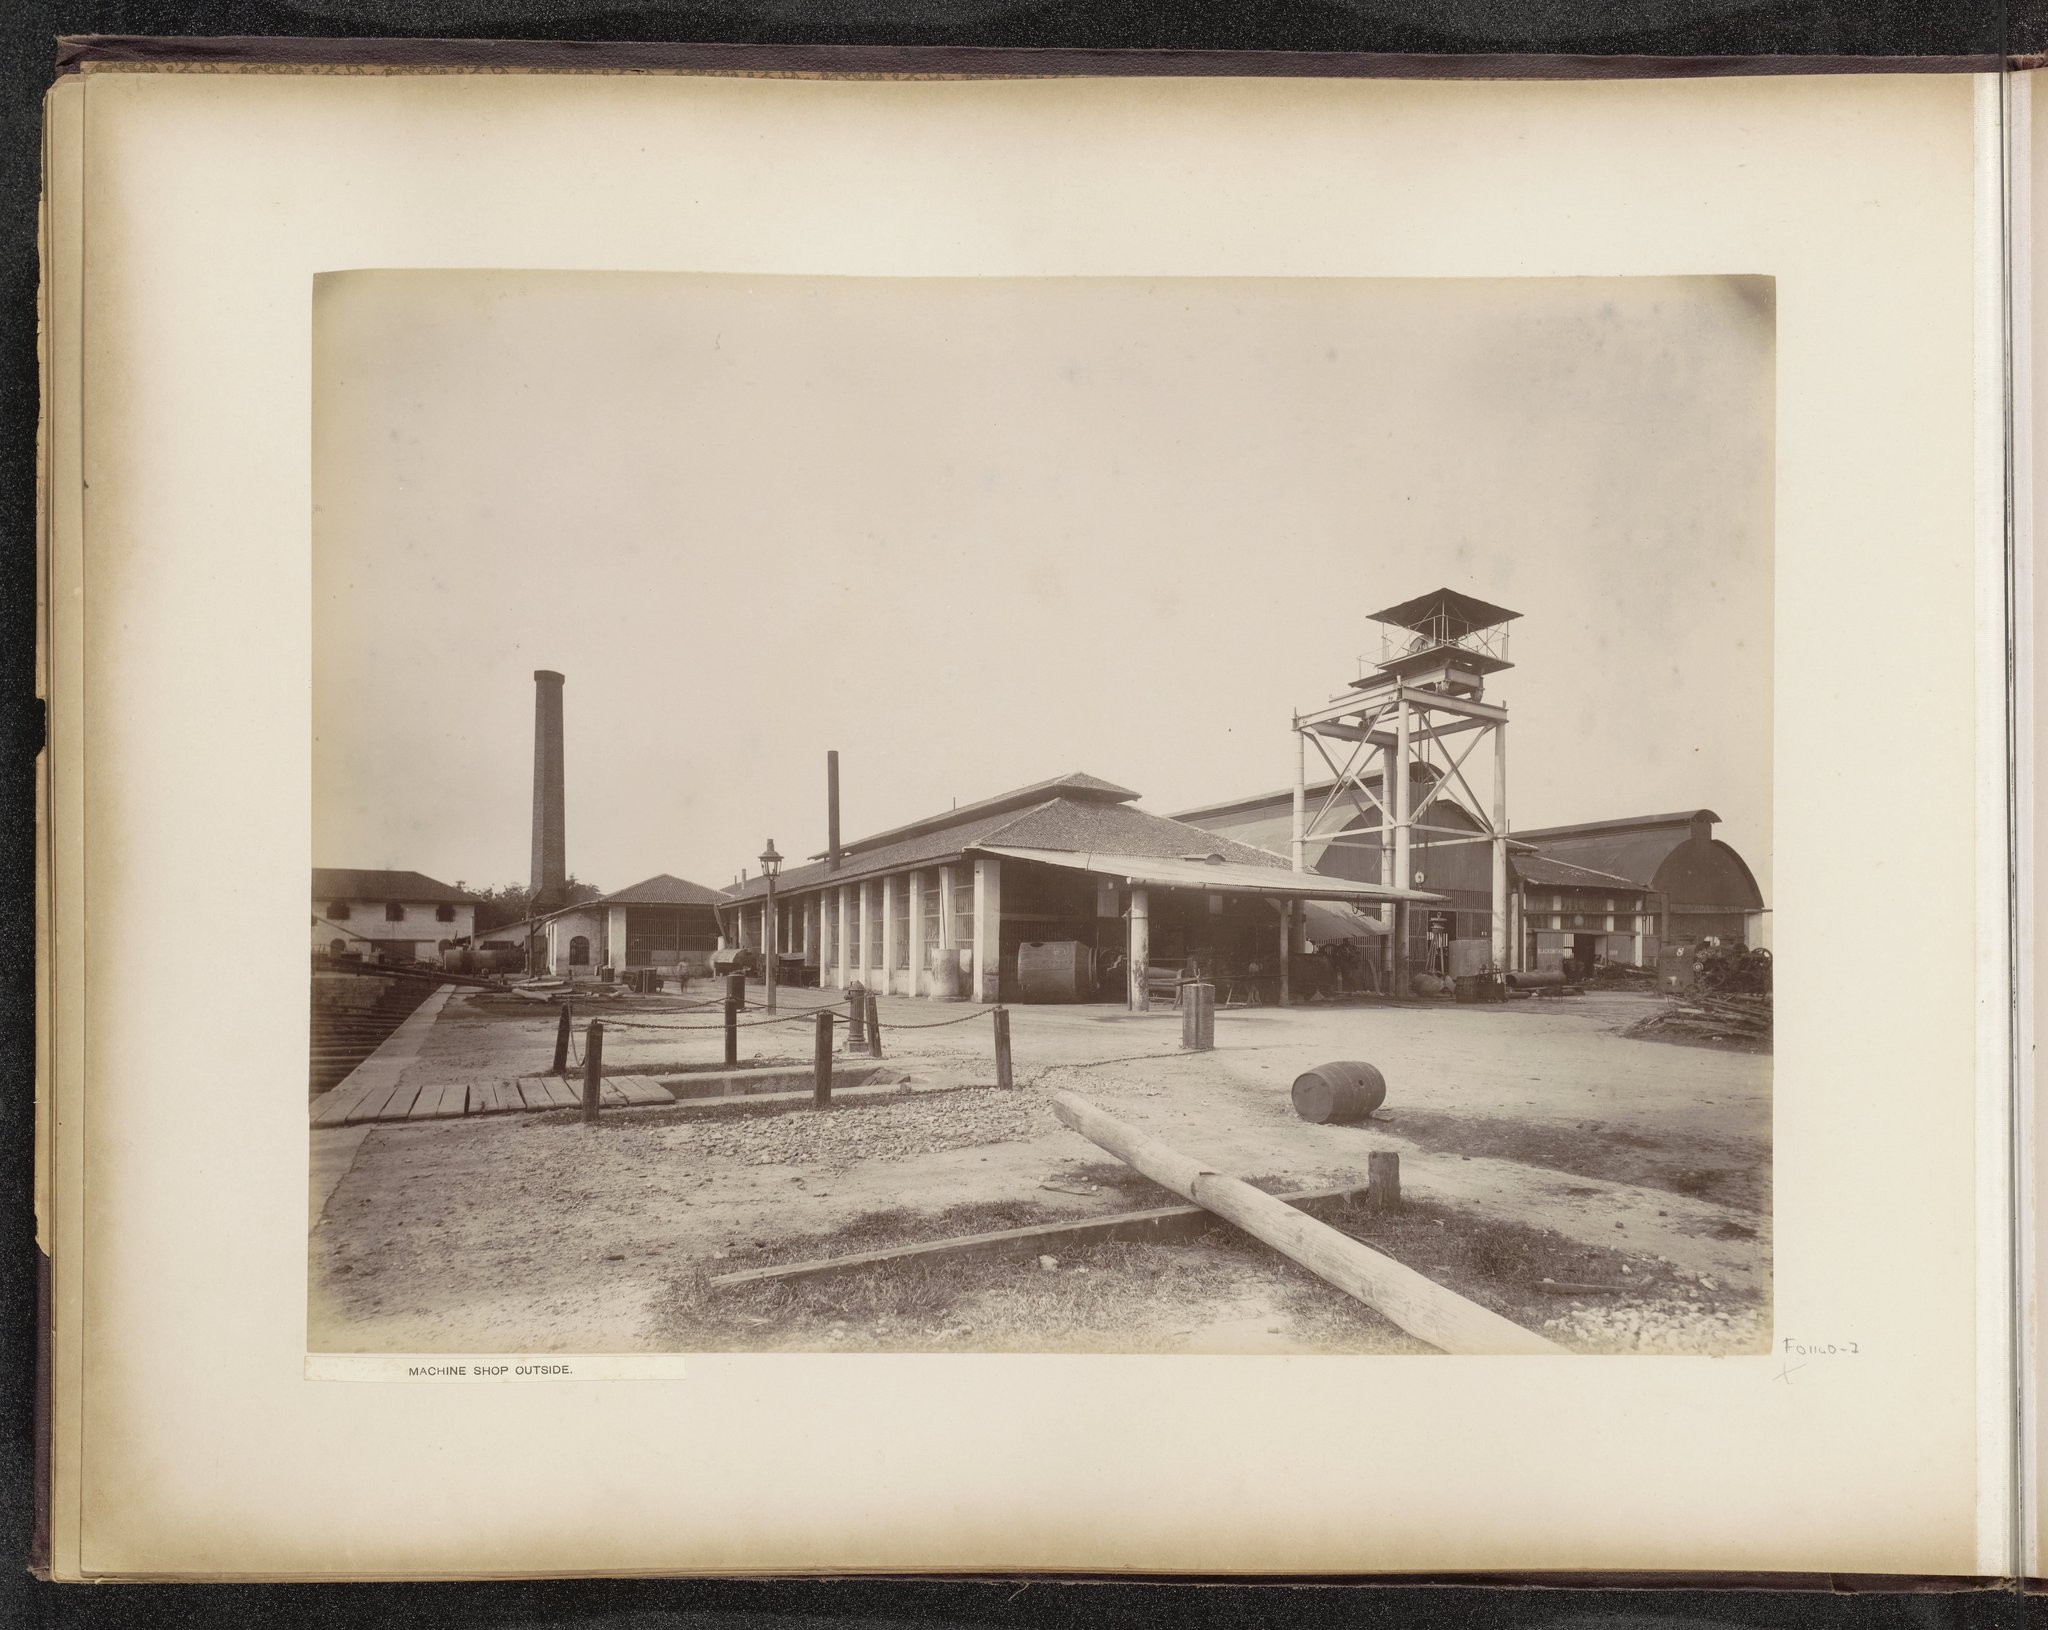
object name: photograph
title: Machine shop outside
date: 1890-1905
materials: photographic support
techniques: albumen print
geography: singapore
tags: factory-interior, machine shop, pier, quay, wharf, shipyard, shipdock, shipbuilding industry, singapore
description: Onderdeel van Fotoalbum van de Tanjong Pagar Dock Co. Ltd. in Singapore.